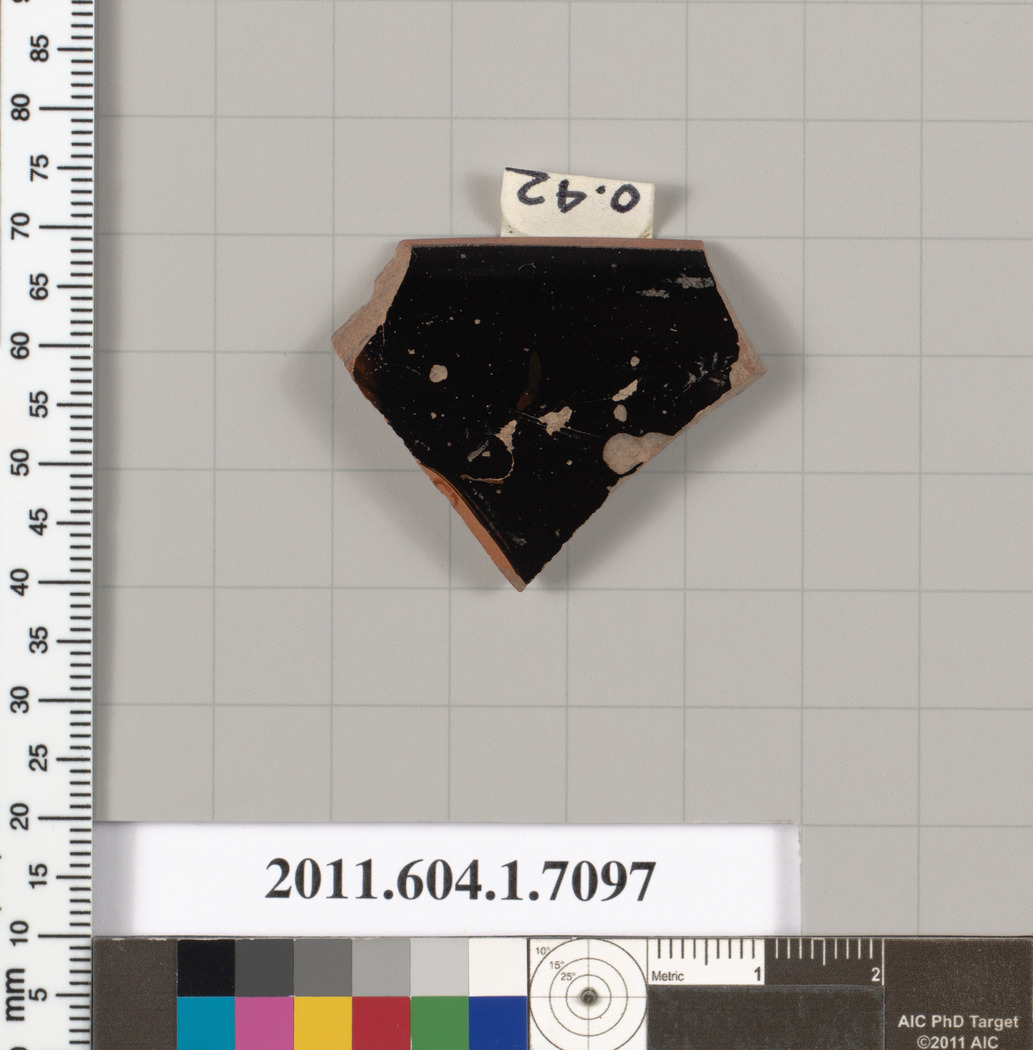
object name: kylix fragment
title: Terracotta rim fragment of a kylix (drinking cup)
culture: greek, attic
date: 500-480 BCE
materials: terracotta